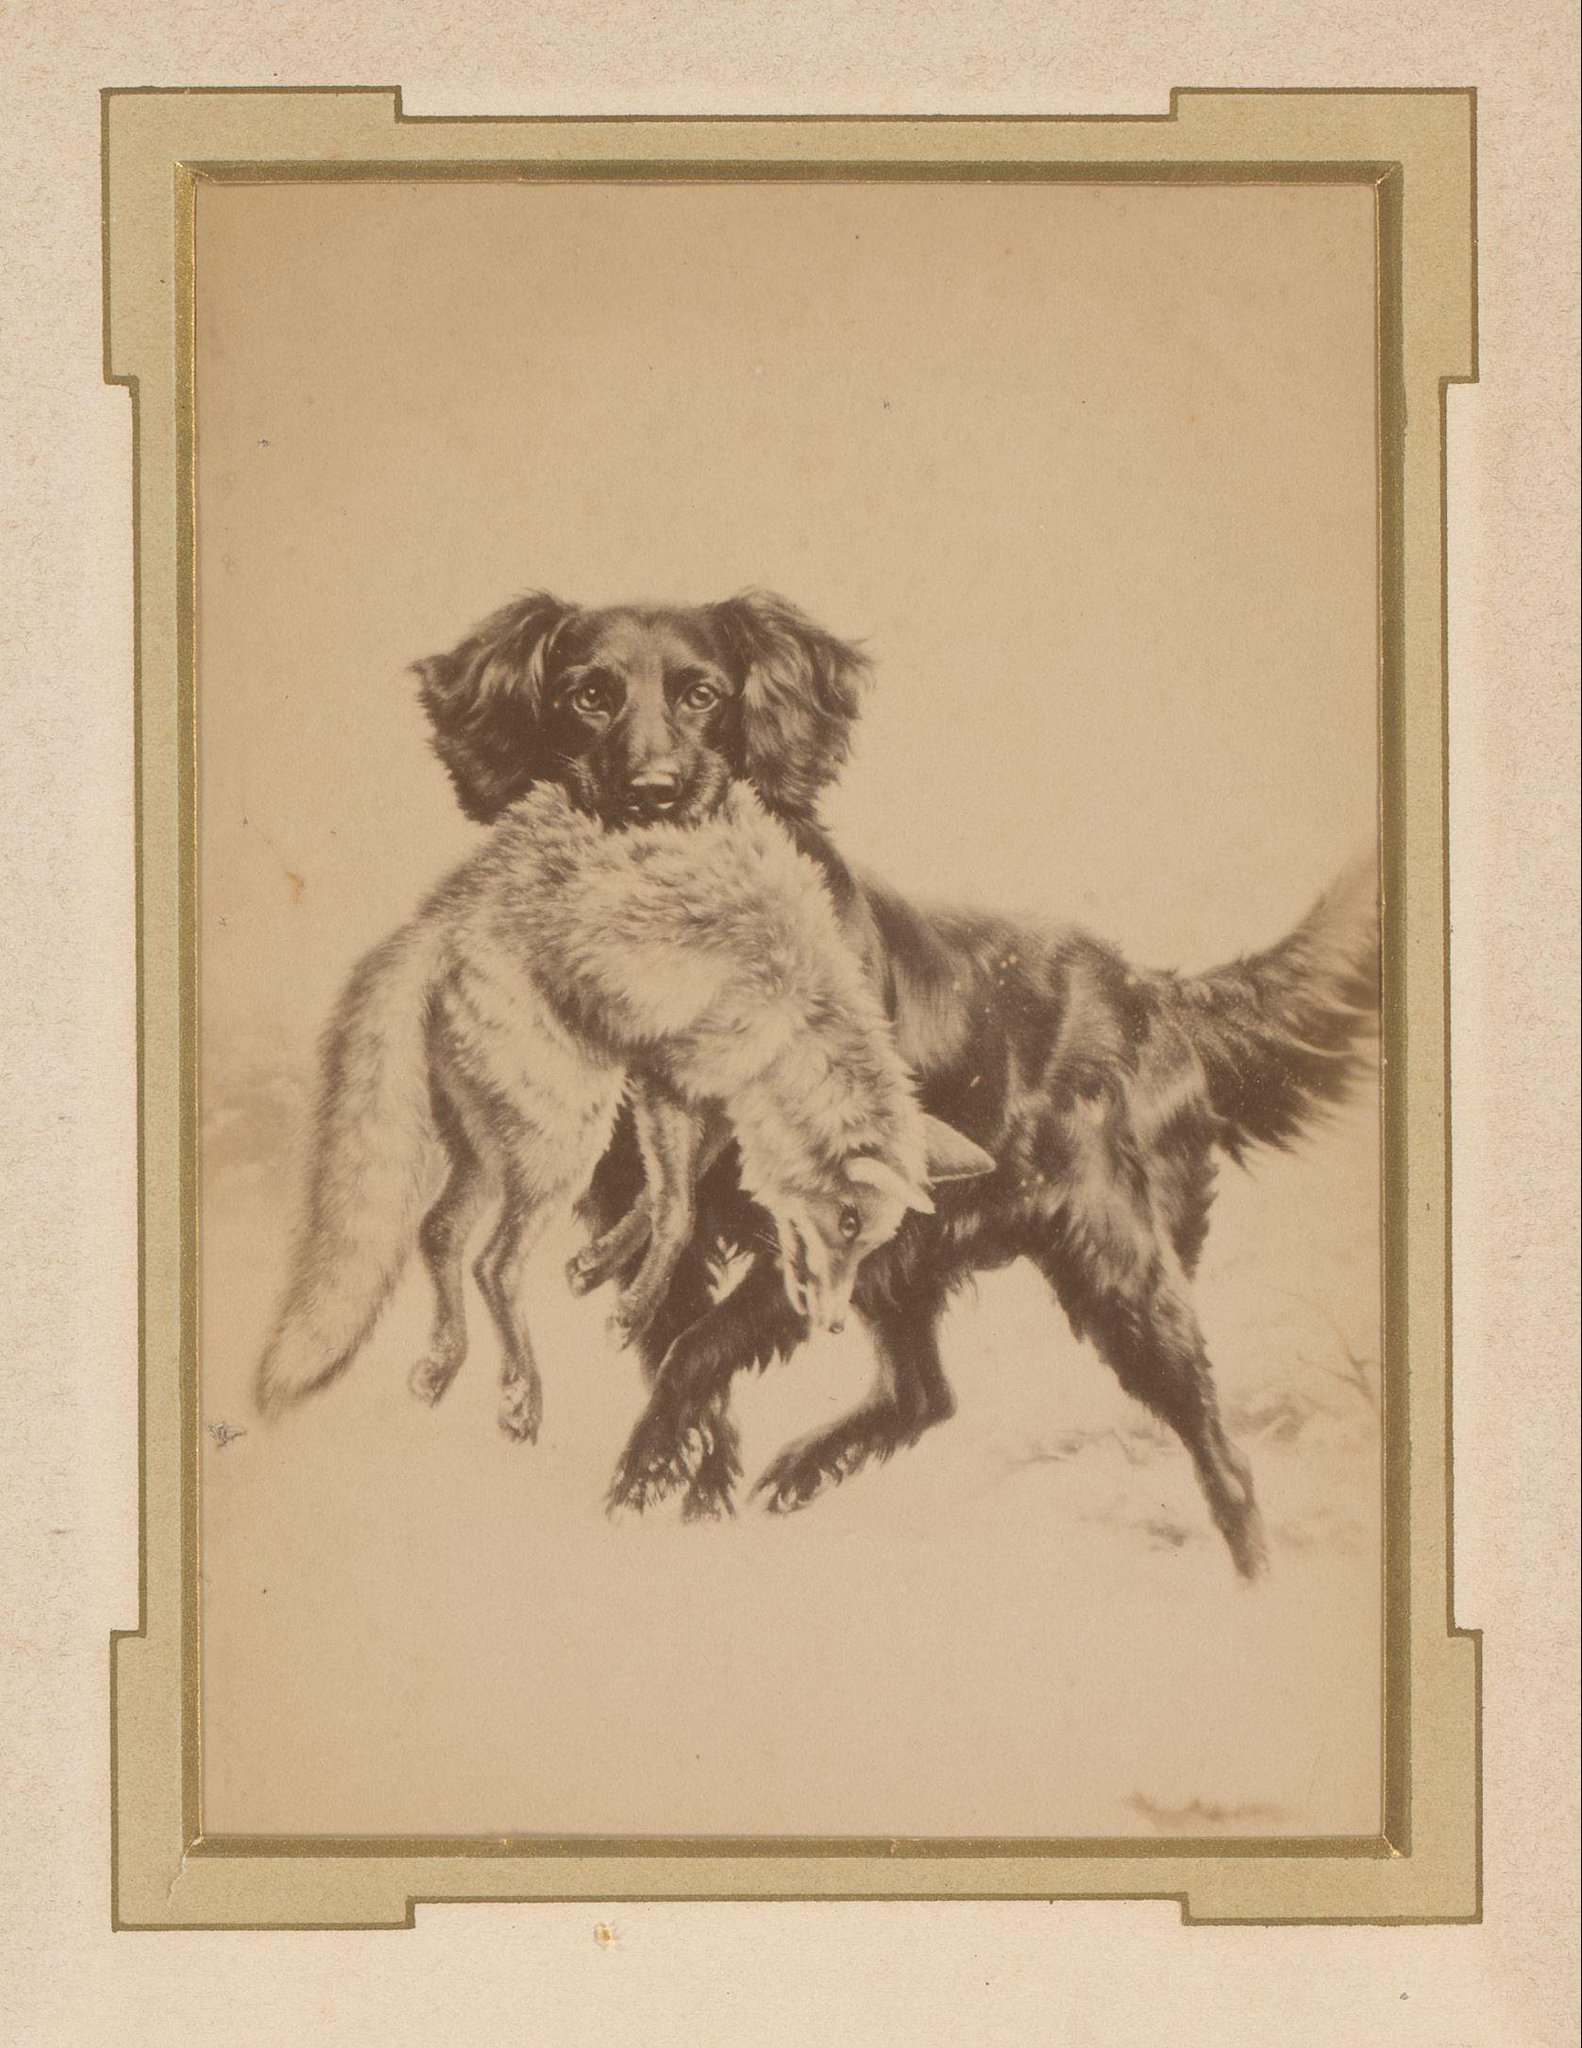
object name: photograph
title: Fotoreproductie van een tekening met een hond met een vos in zijn bek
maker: Anonymous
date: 1870-1900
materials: cardboard, photographic support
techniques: albumen print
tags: fox and hounds, dog, beasts of prey, predatory animals: fox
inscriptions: inscription: ‘Collection Universelle’